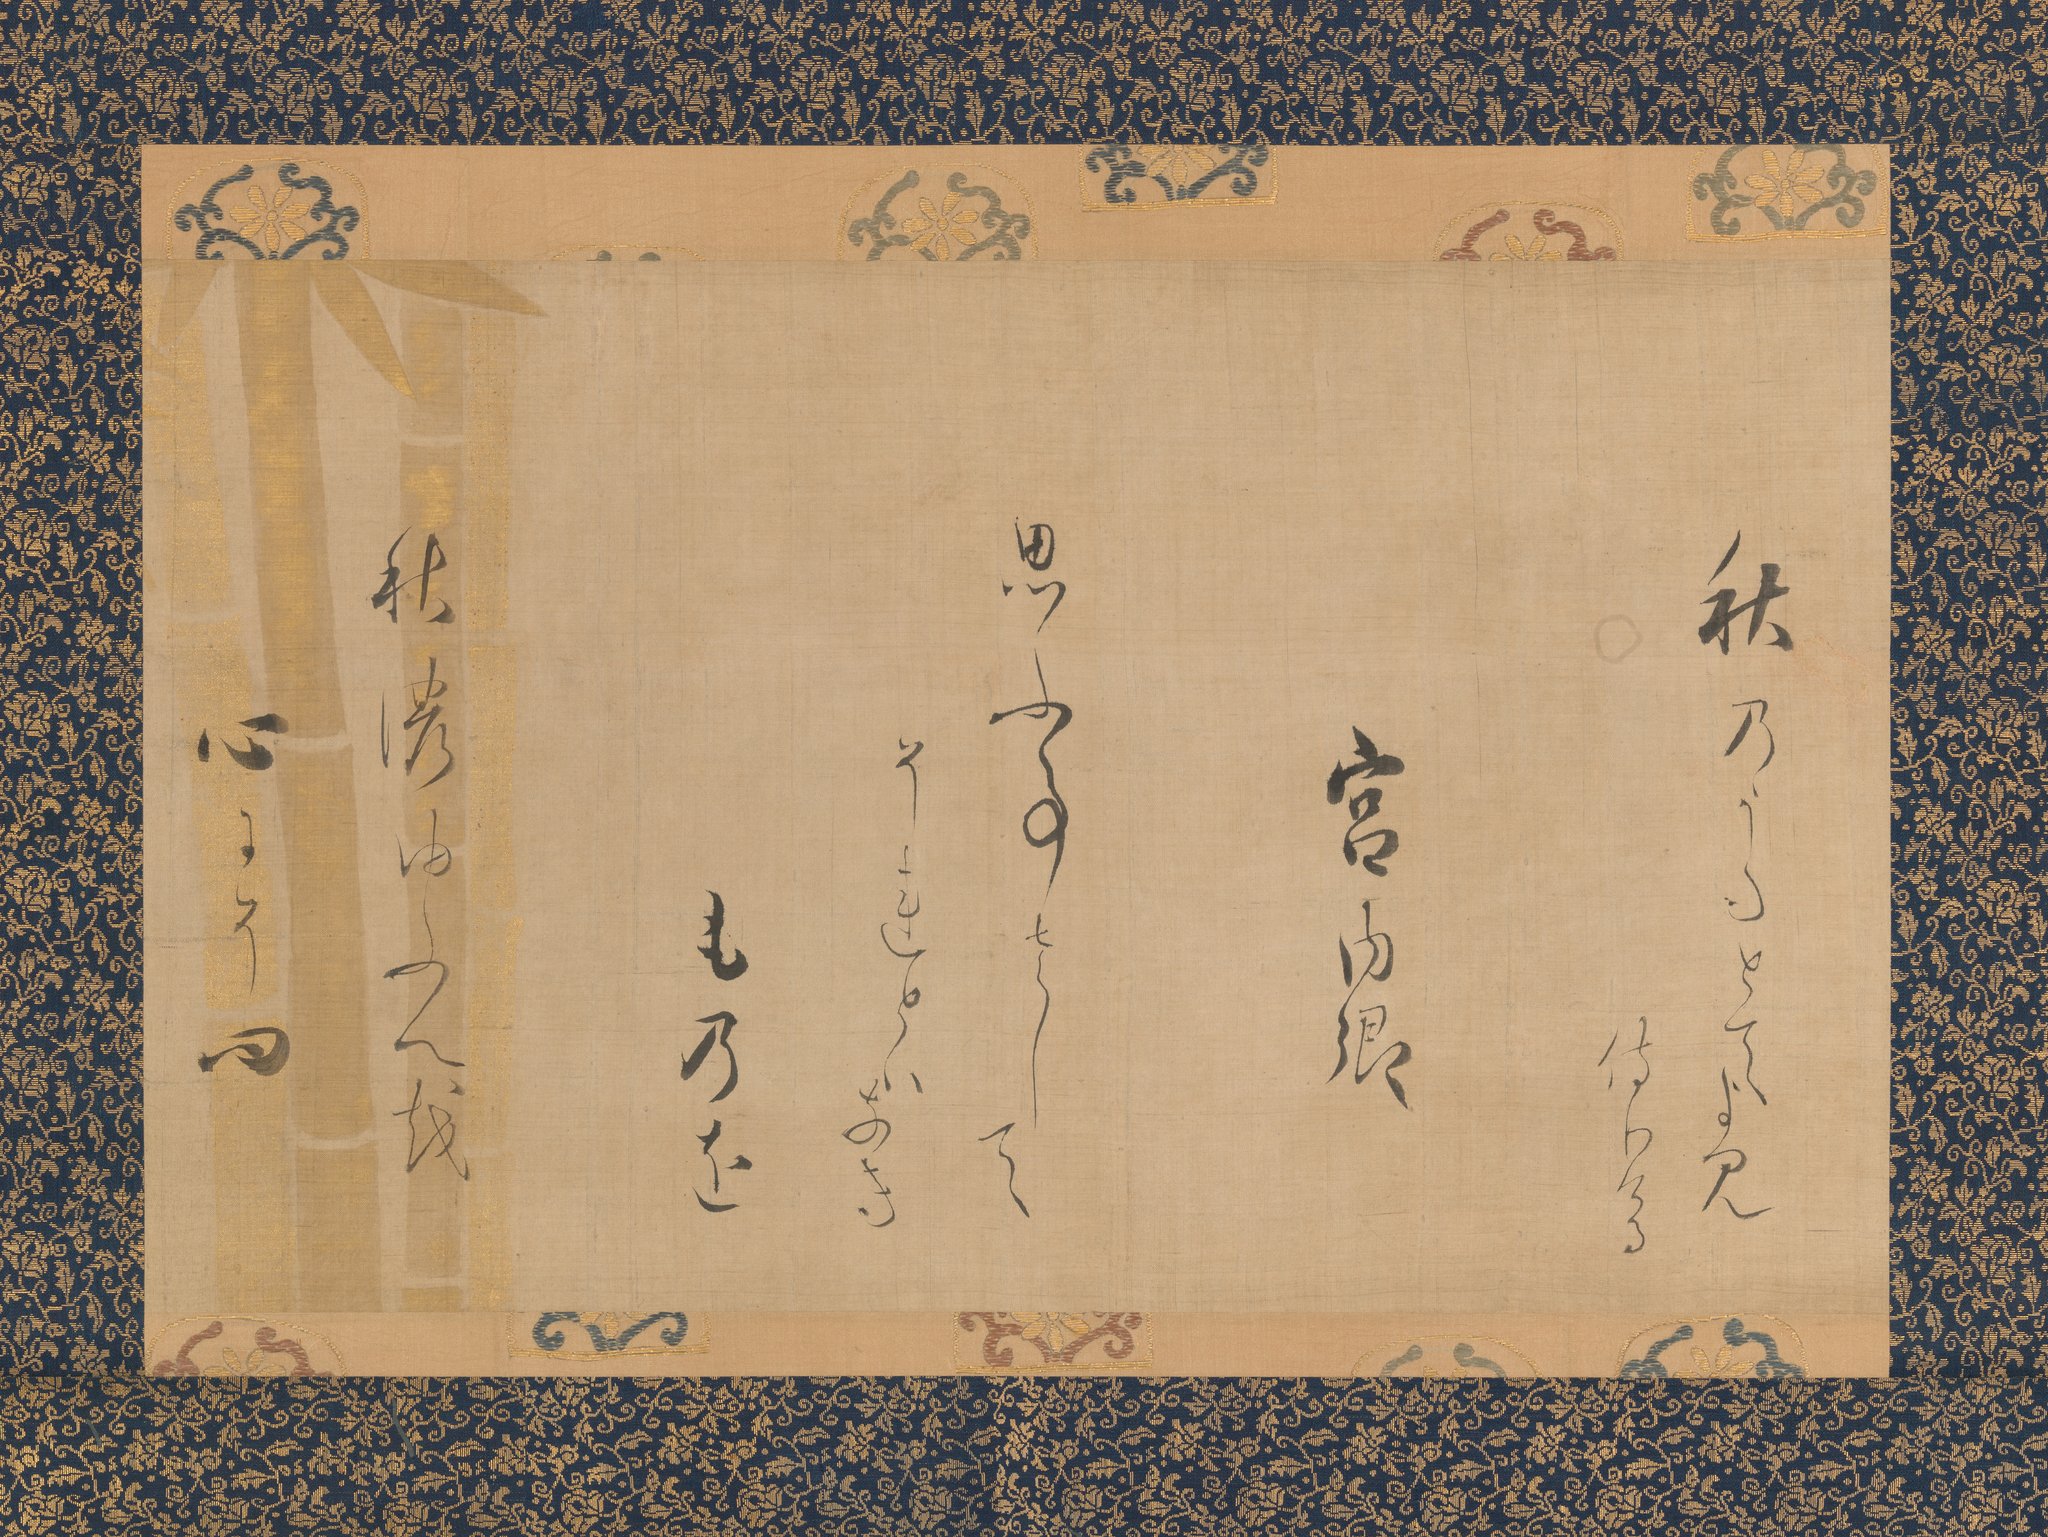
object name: hanging scroll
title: Autumn Poem by Lady Kunaikyō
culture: japanese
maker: hon'ami kōetsu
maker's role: artist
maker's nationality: japanese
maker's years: 1558-1637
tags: poetry,calligraphy